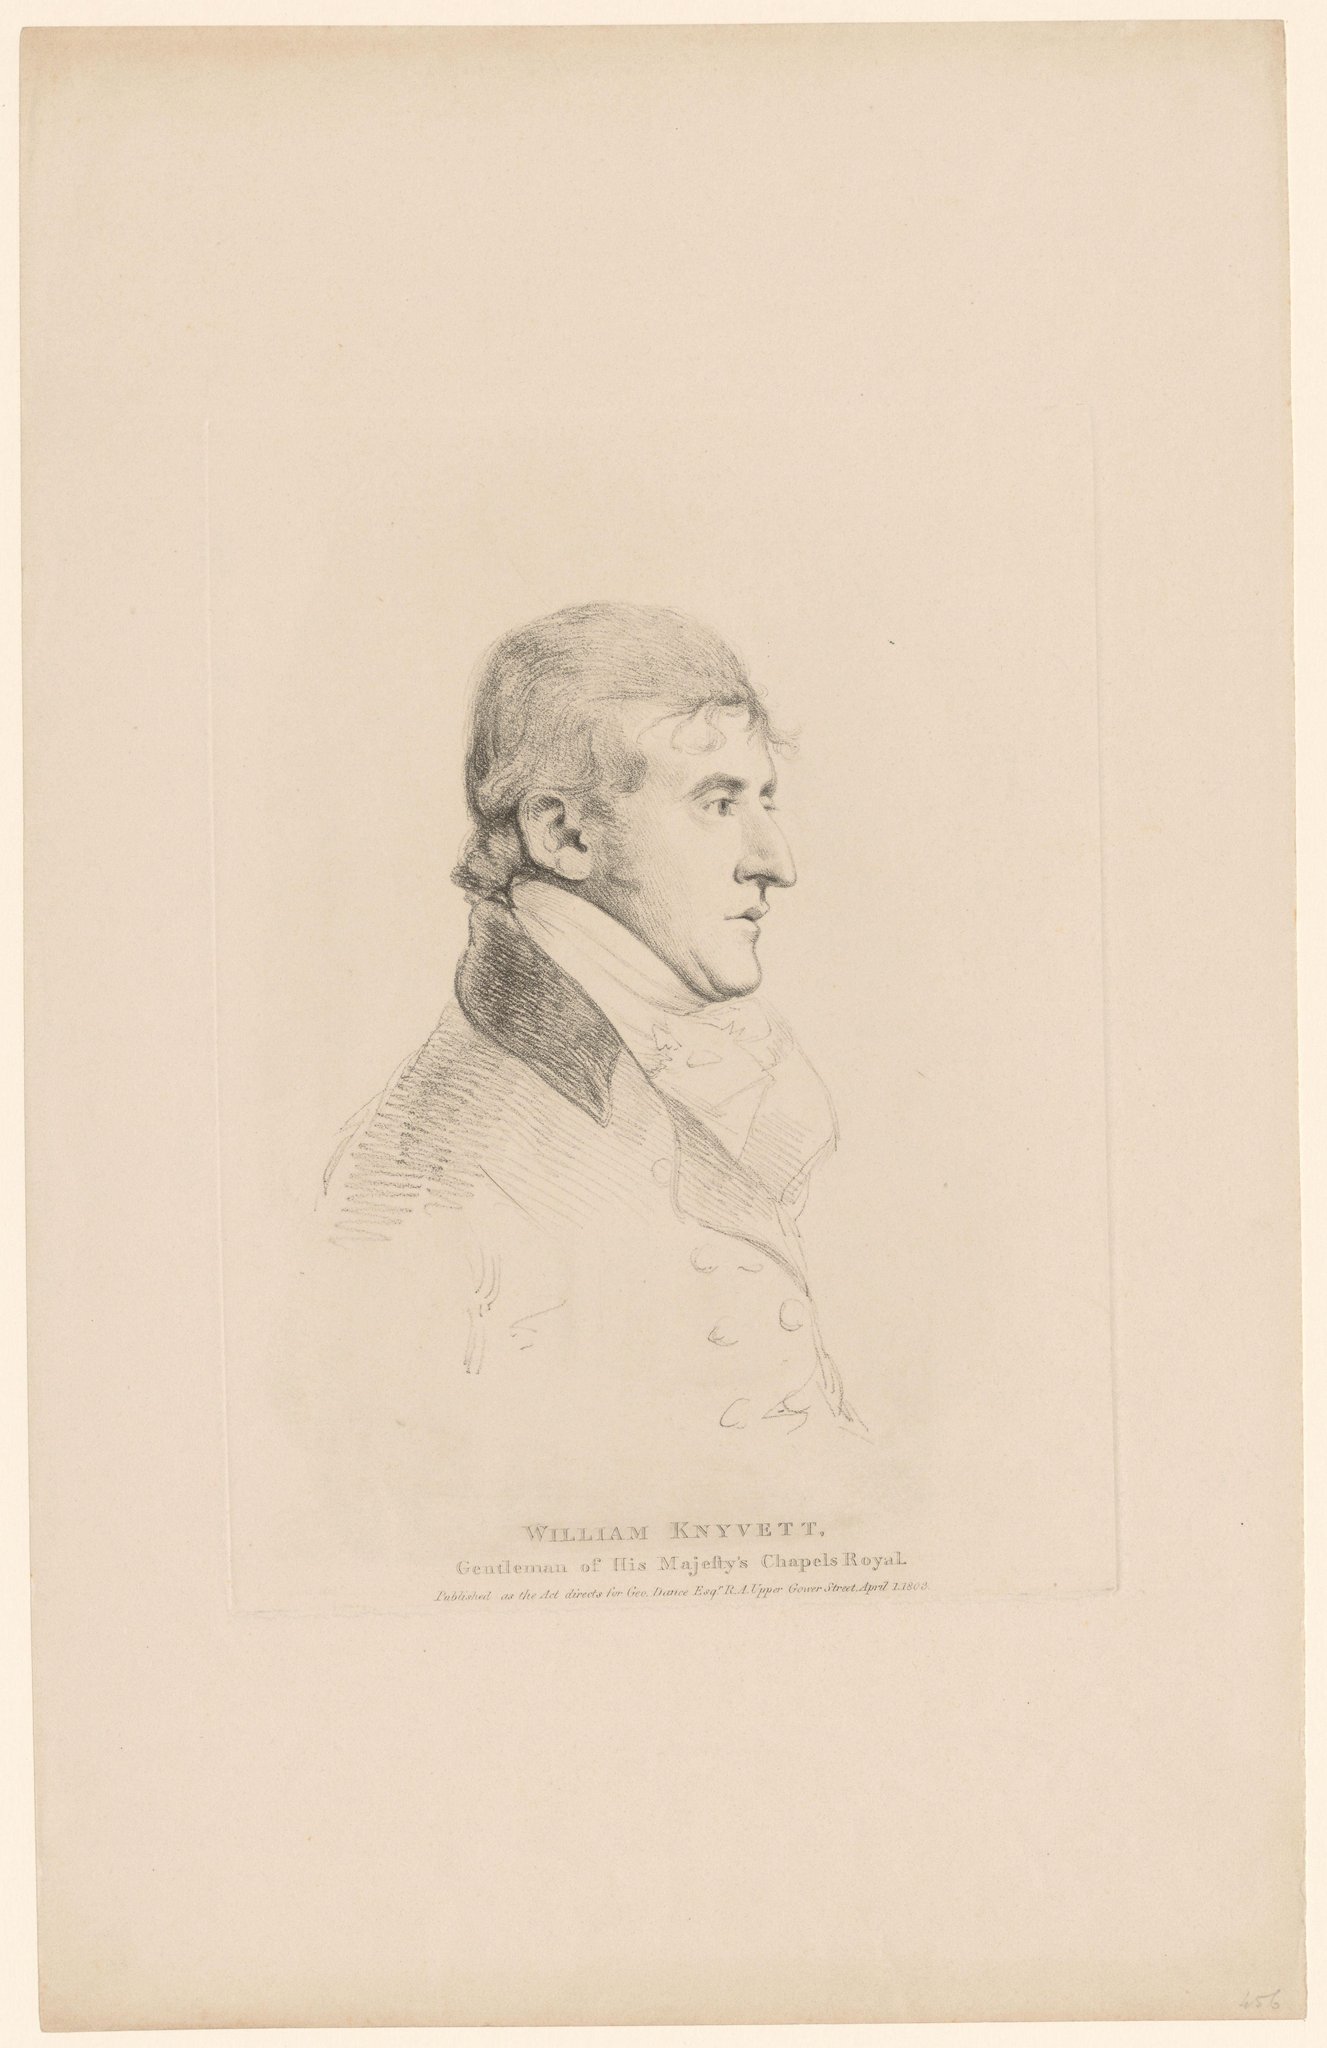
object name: print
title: Portret van William Knyvett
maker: william daniell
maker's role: artist, print maker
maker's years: 1769-1839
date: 1803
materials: paper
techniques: printmaking, etching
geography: london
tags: historical persons, portrait of composer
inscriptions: collector's mark: Lugt 2228